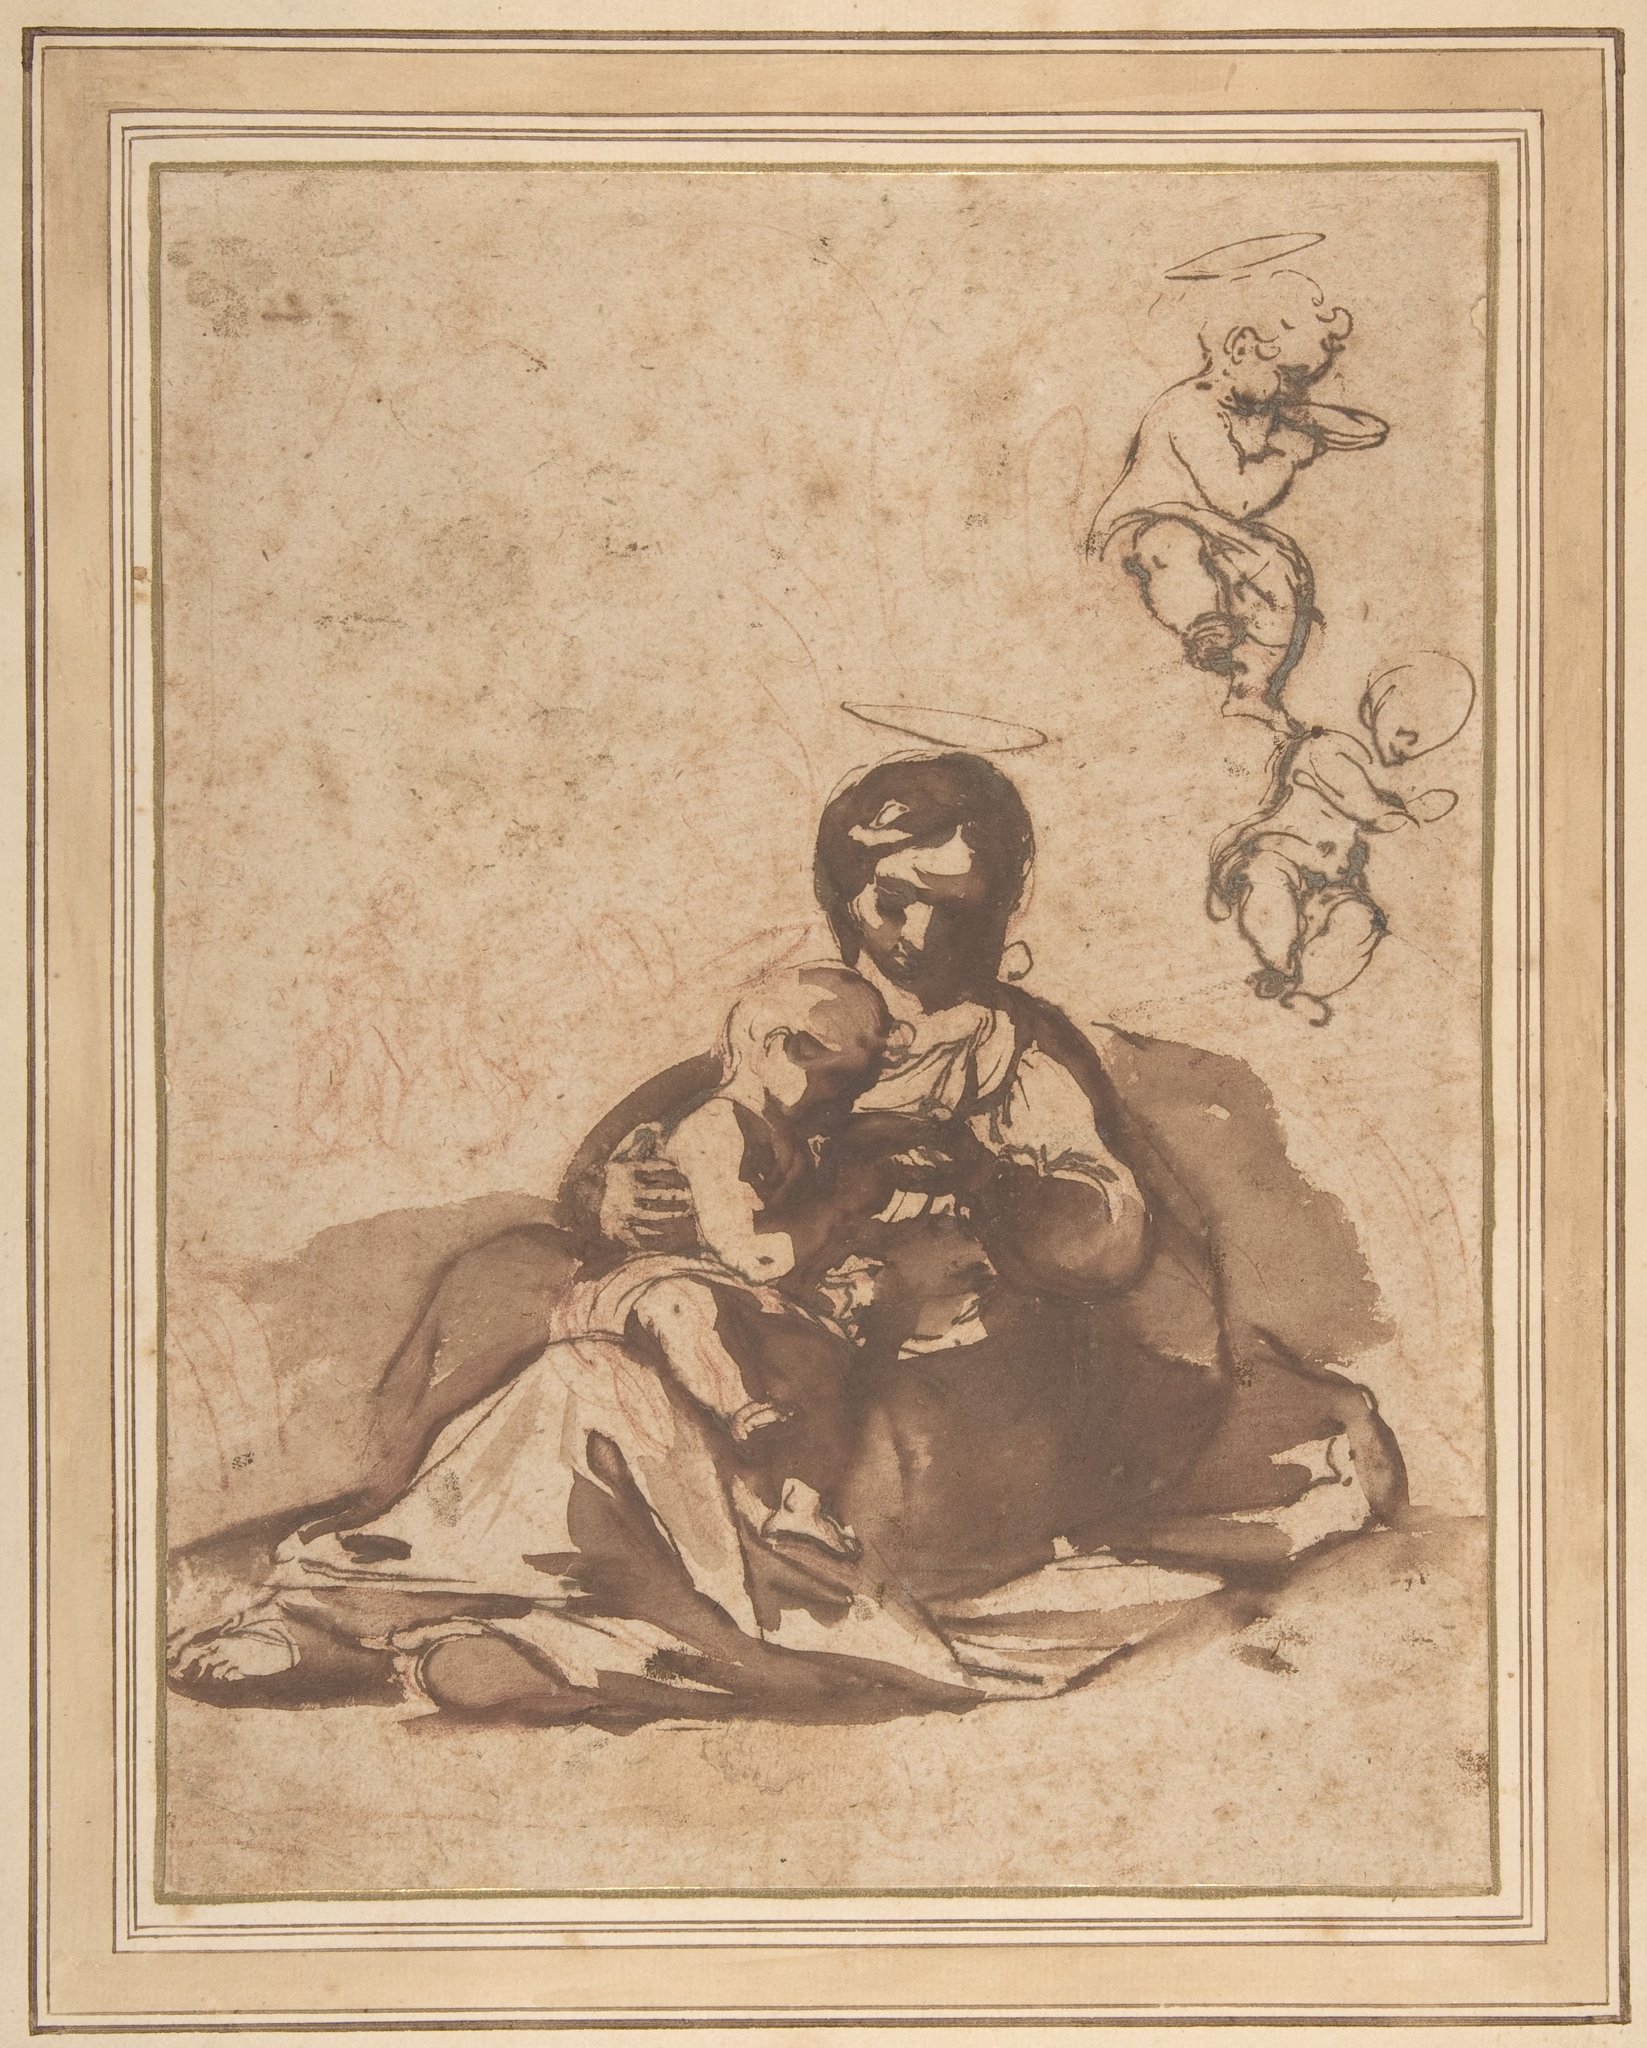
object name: drawing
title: Studies for a Rest on the Flight into Egypt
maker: rutilio manetti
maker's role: artist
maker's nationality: italian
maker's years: 1570-1639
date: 1571-1639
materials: chalk, ink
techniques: brush, pen, wash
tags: madonna and child